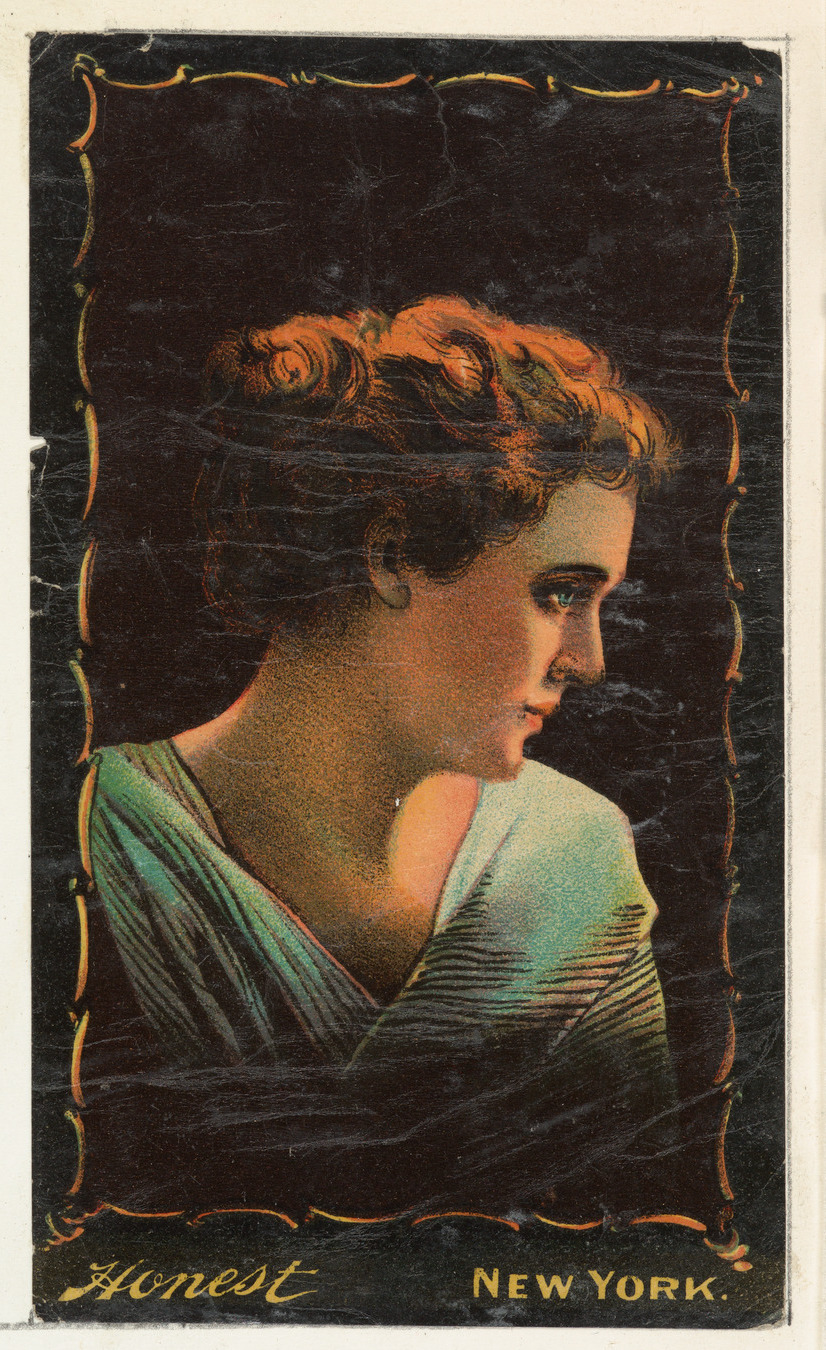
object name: print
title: Portrait of actress in profile facing right, from the Transparencies series (N137) issued by W. Duke, Sons & Co. to promote Honest Long Cut Tobacco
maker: w. duke, sons & co.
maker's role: publisher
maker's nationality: american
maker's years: 1870-1920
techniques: color lithograph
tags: profiles,women,actresses